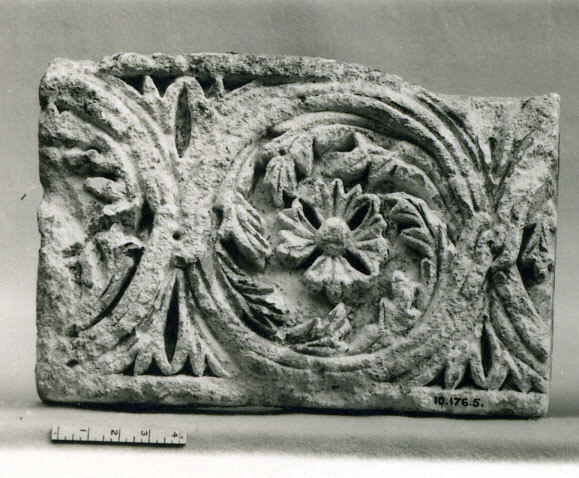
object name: fragment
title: Fragment of a Frieze with a Sequence of Roundels Enclosing Rosettes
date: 401-600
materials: limestone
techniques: carving, relief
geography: egypt